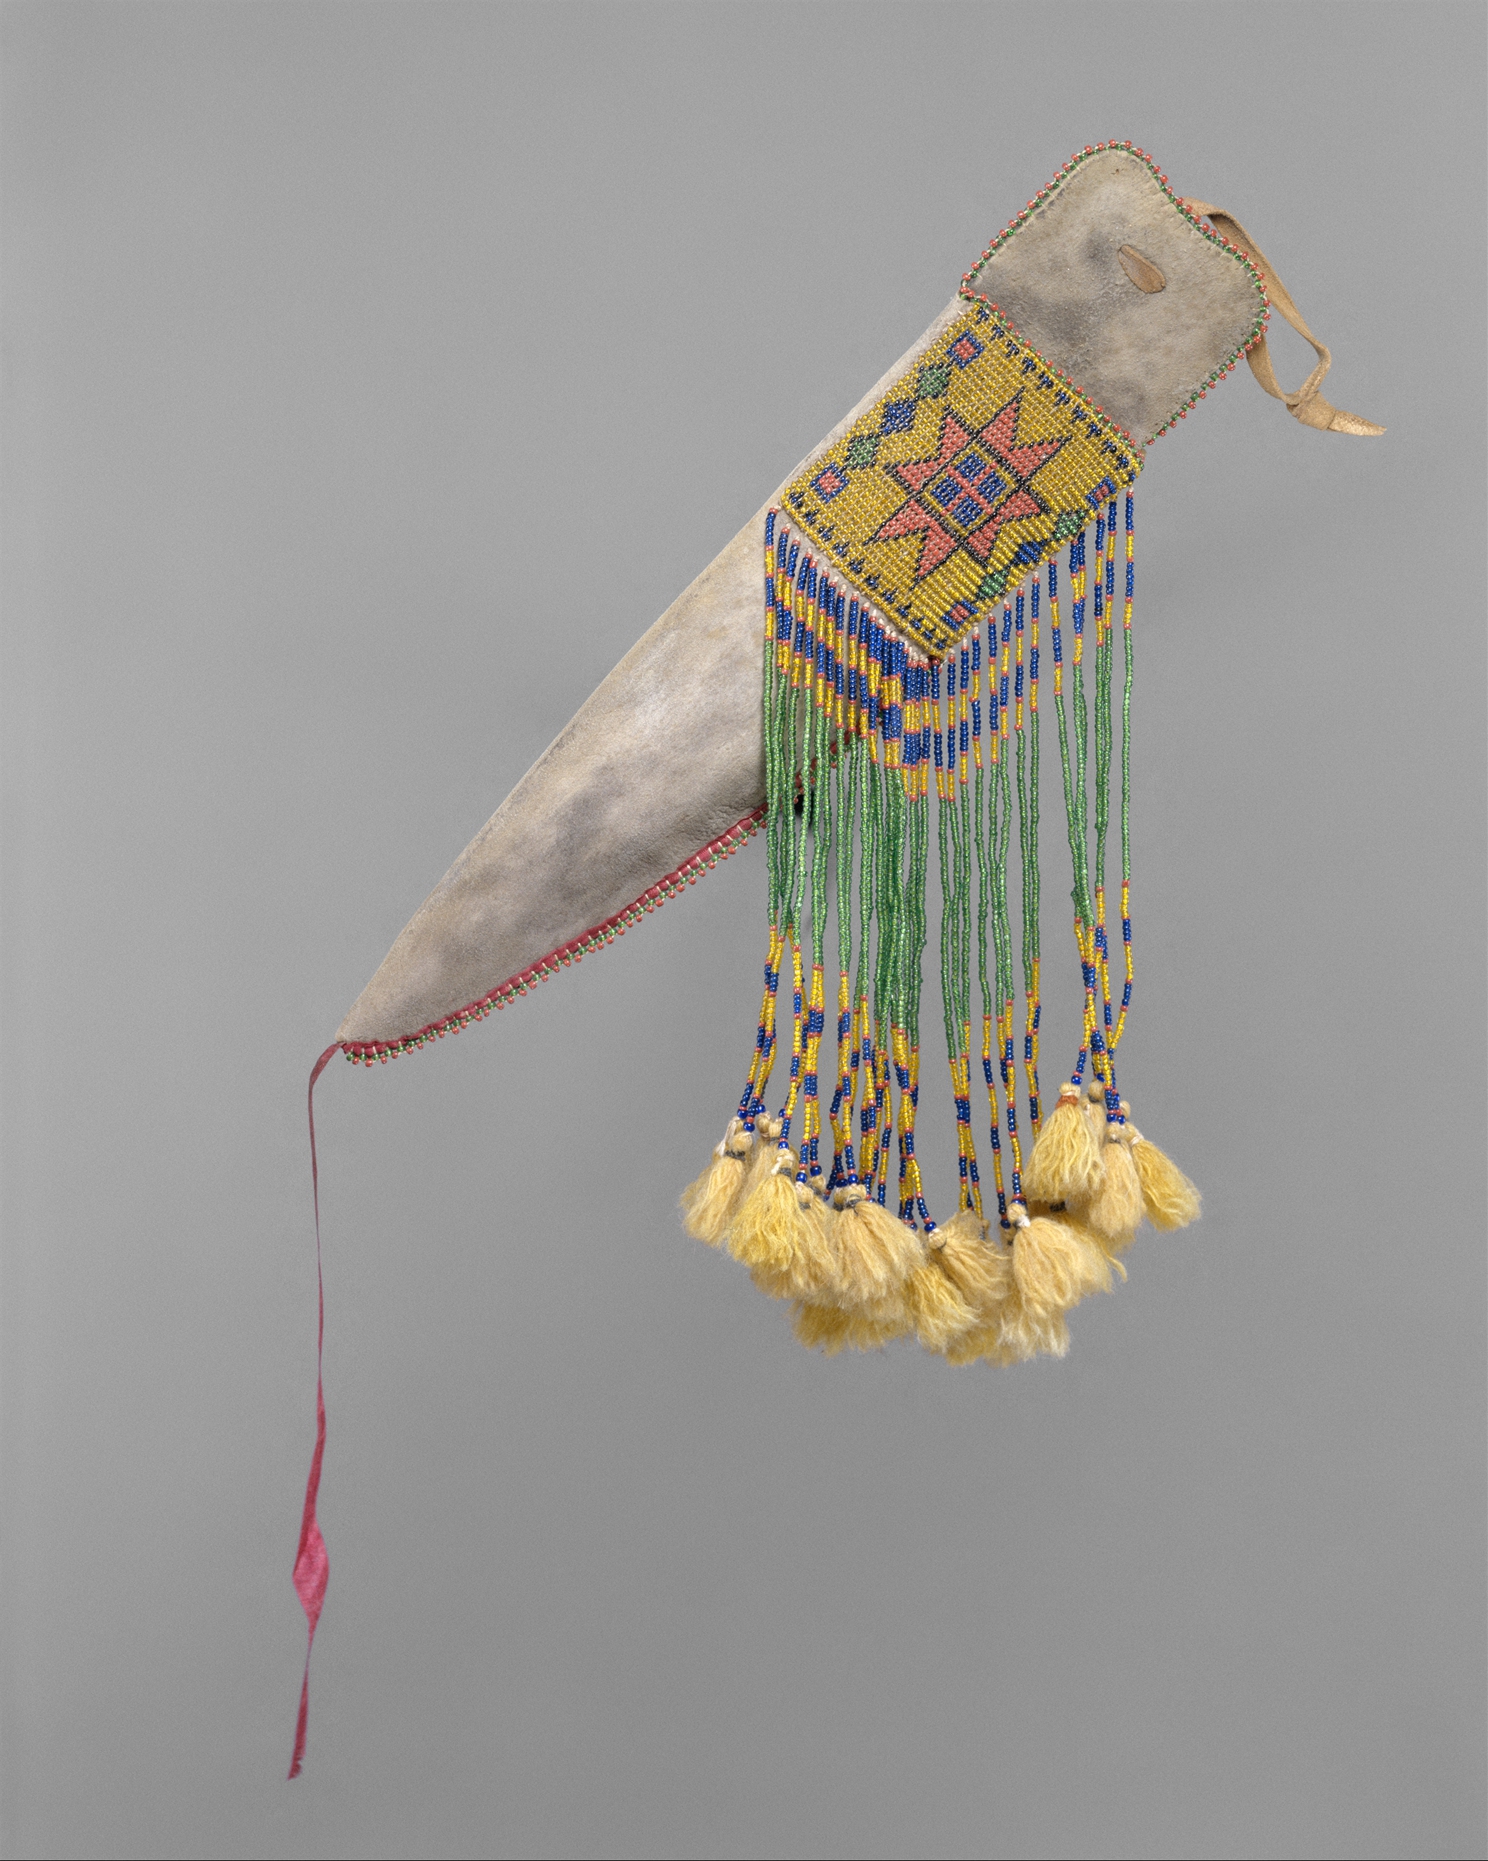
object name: knife with sheath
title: Knife Case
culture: ojibwa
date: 1843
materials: glass, silk, skin, wool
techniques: tanning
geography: united states